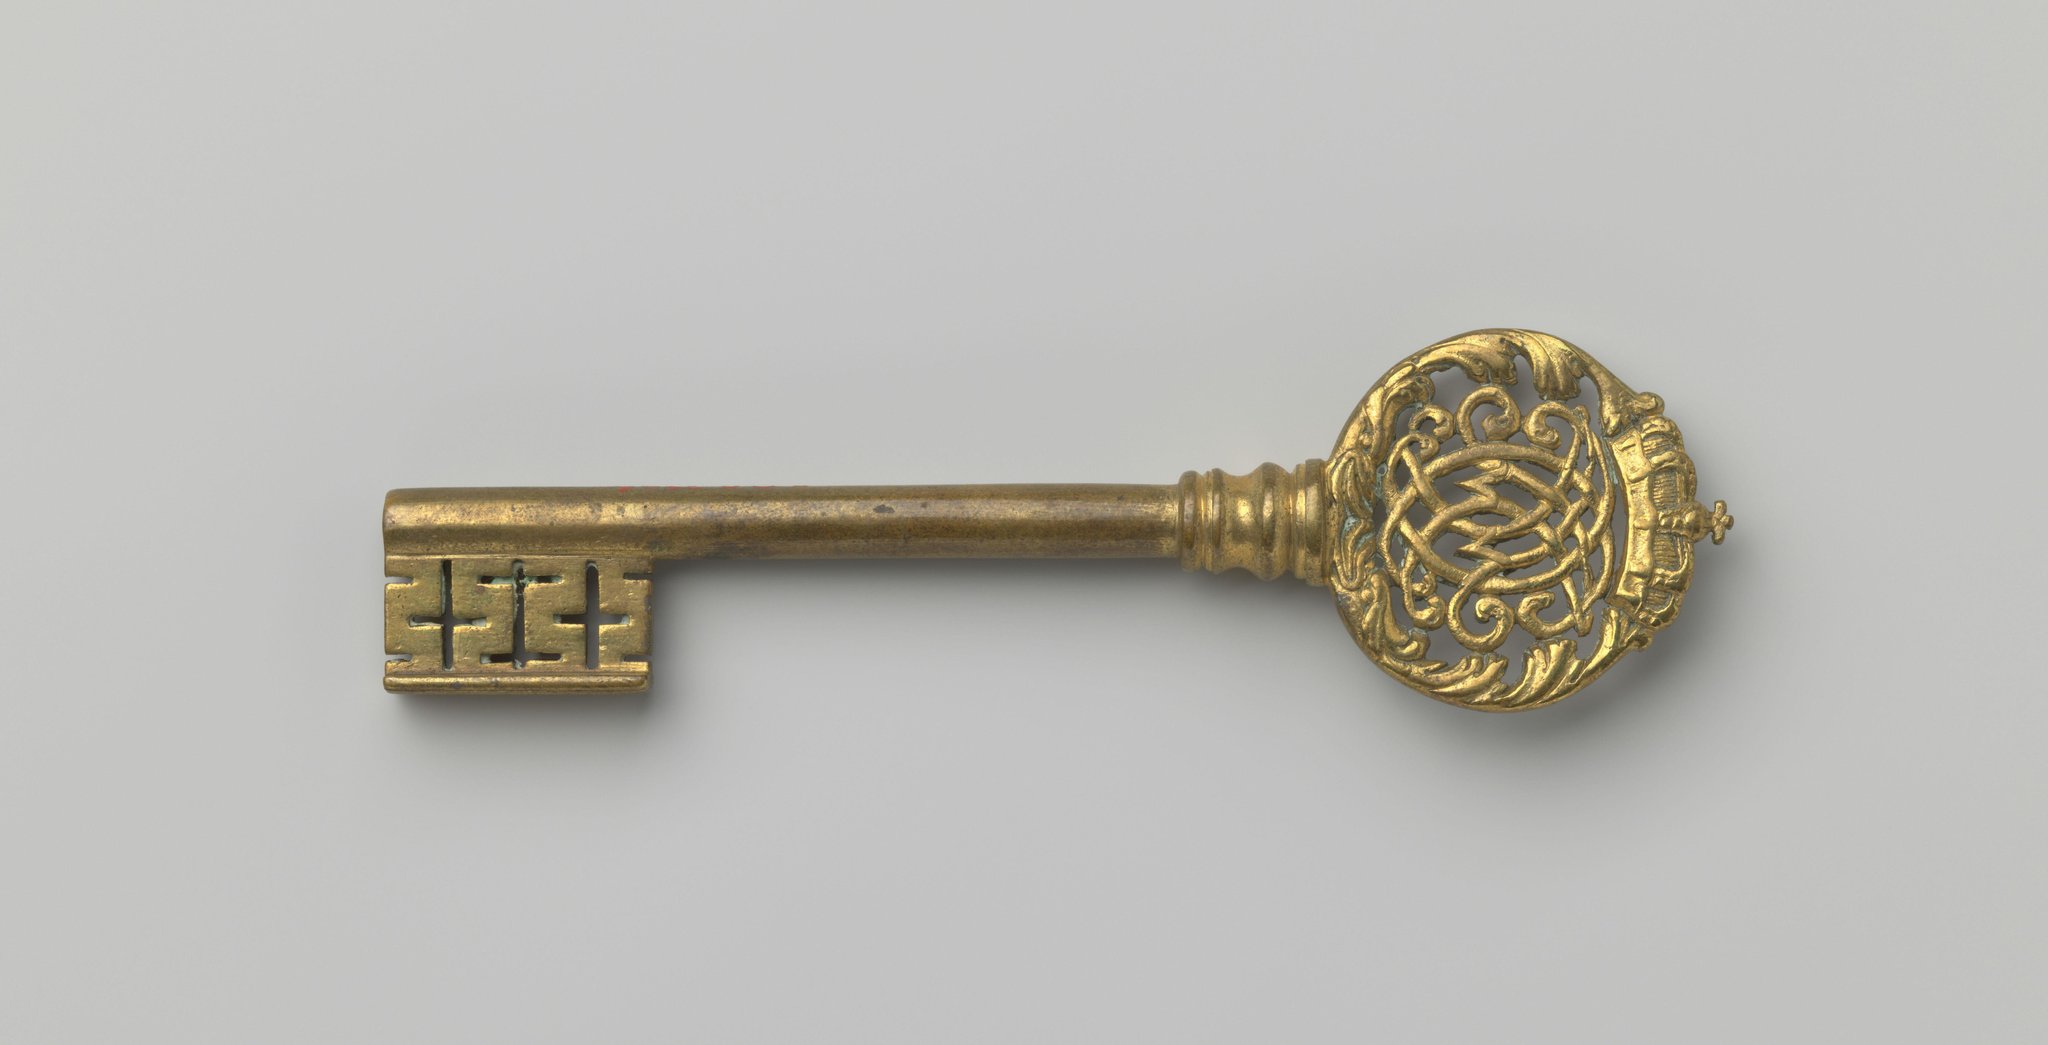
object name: kamerheersleutel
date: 1700-1800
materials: copper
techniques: gilding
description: Geboorde kamerheersleutel waarvan de ronde greep gevormd wordt door het monogram A.C., ingesloten door twee bladranken, die onderaan in vissekoppen overgaan en boven een koningskroon insluiten. De schacht en baard doen vermoeden dat de sleutel ook voor het openen van sloten gebruikt werd.